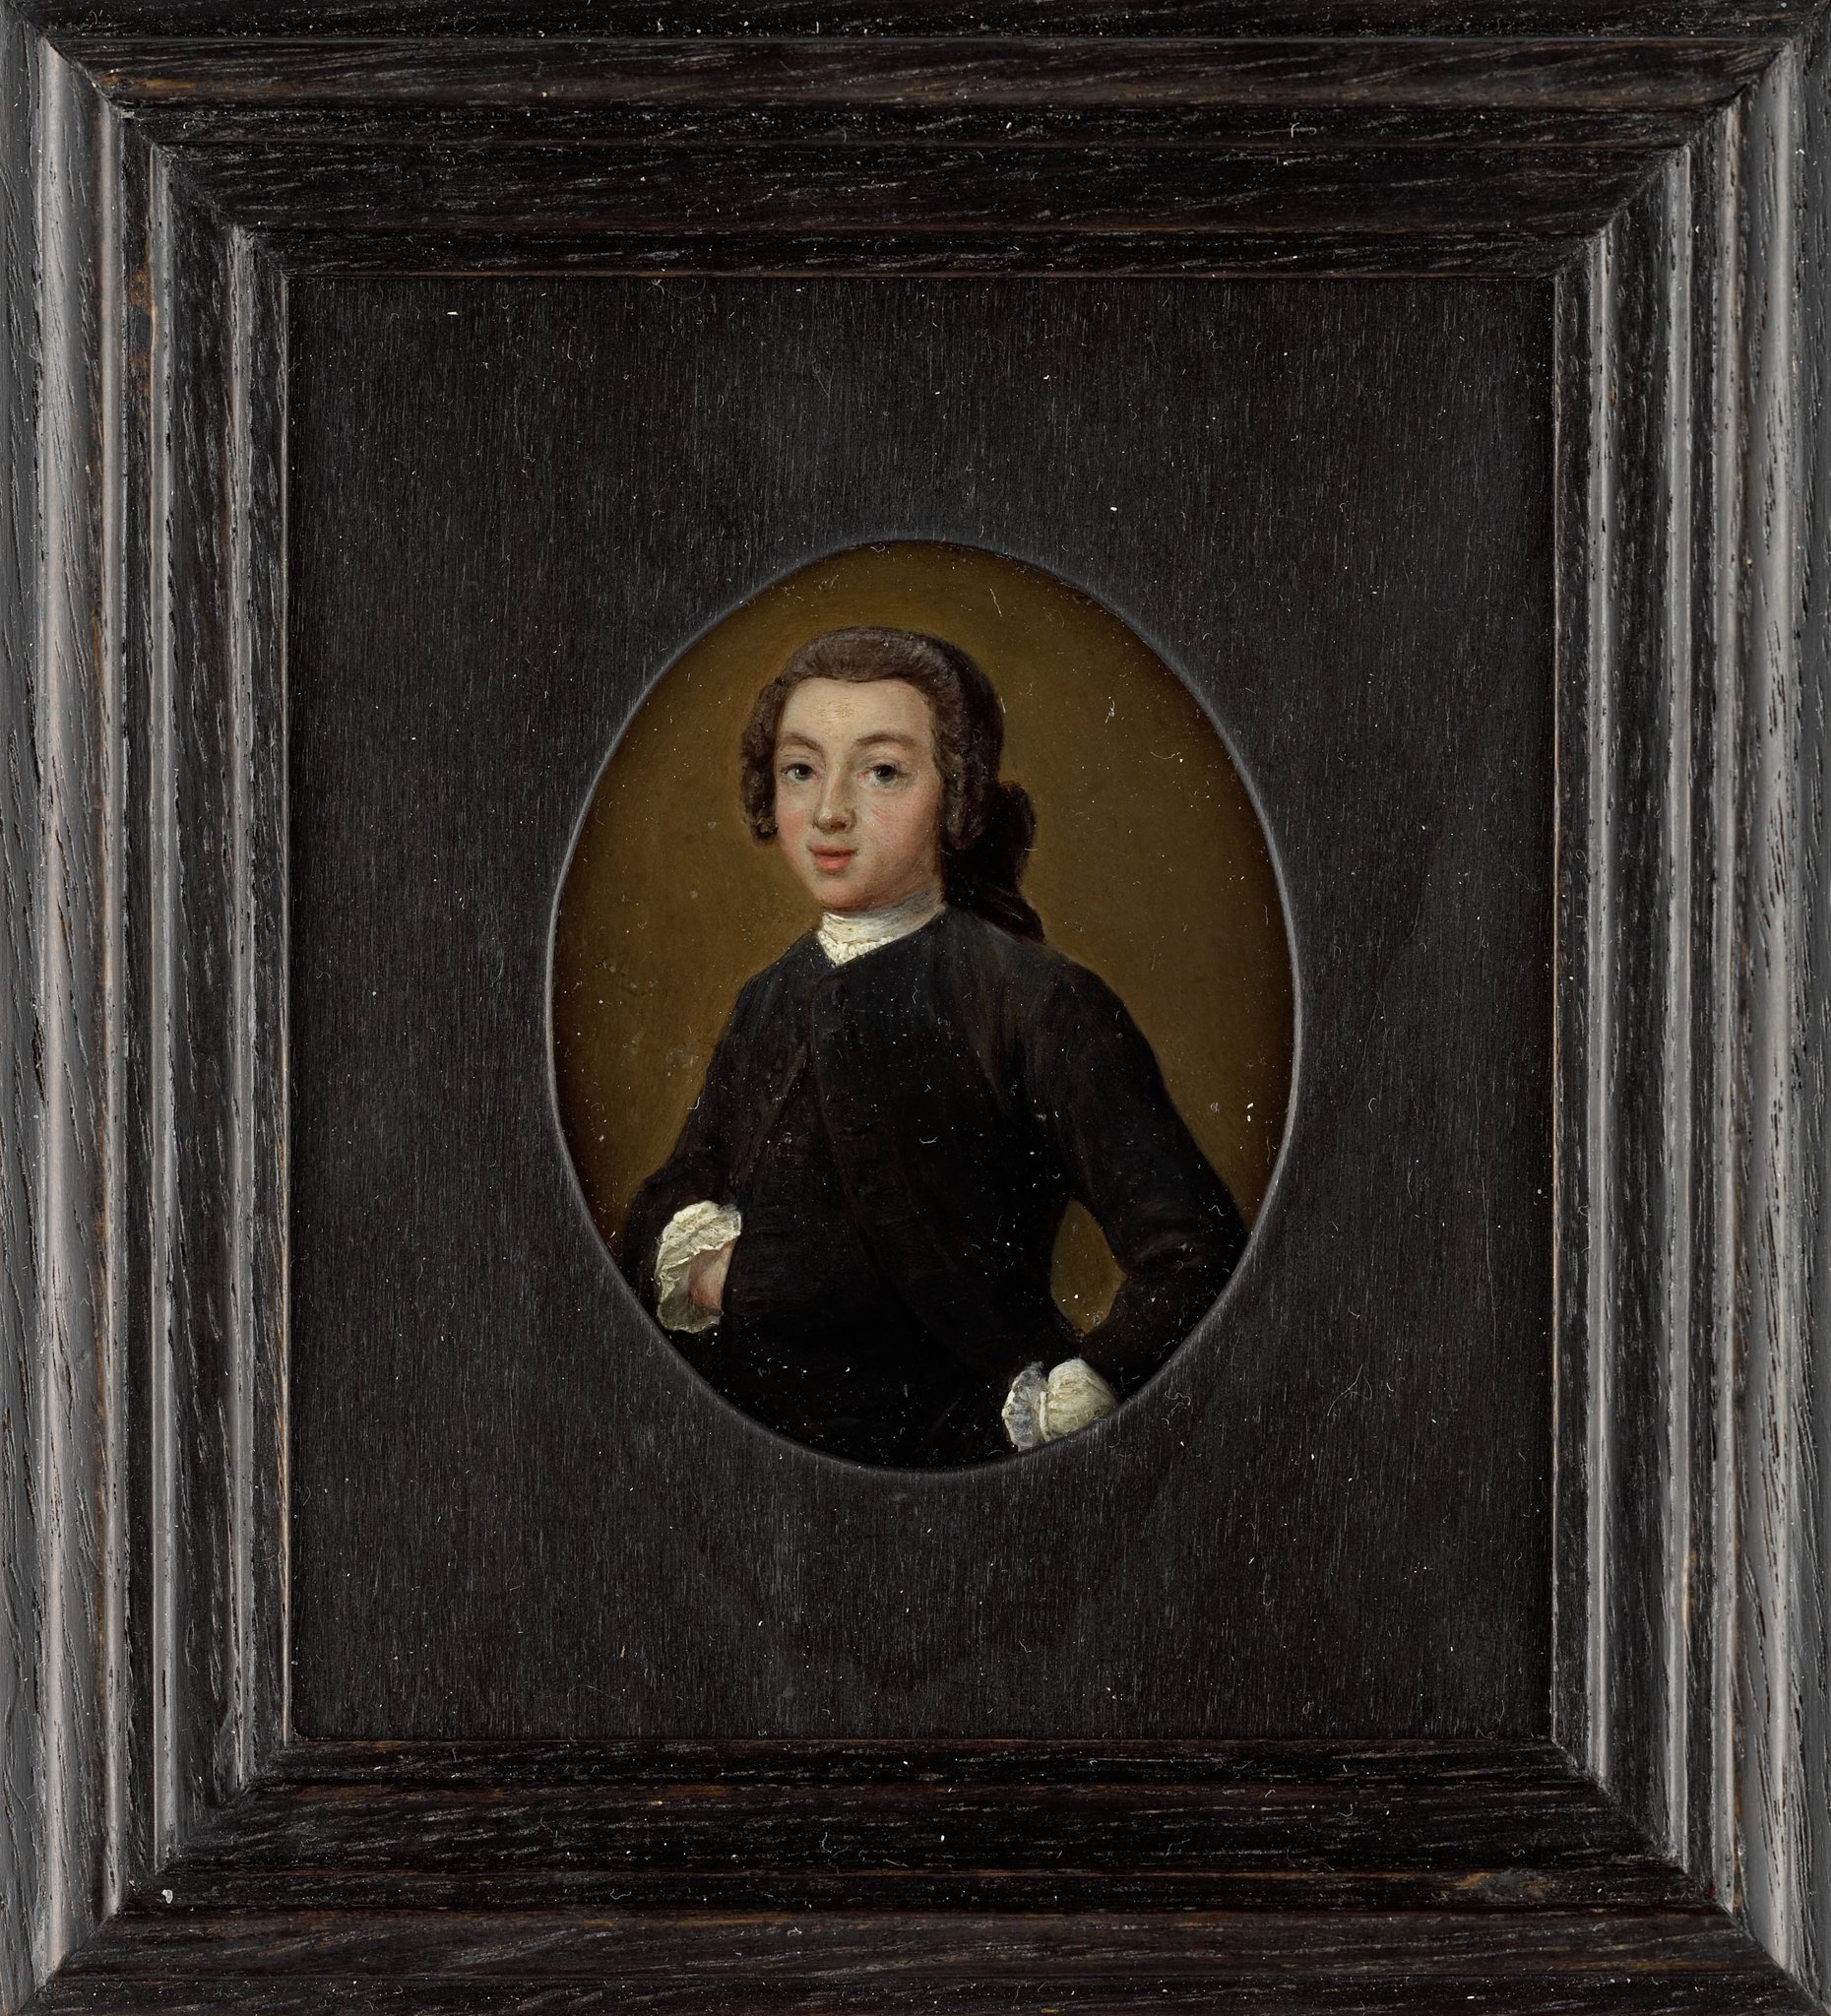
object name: painting, miniature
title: Portret van een jonge man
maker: Anonymous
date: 1745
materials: copper, wood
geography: northern netherlands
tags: anonymous historical person portrayed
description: Portret van een jonge man. Ten halven lijve, naar links, de rechterhand in de vest gestoken, de beschouwer aanziend. Onderdeel van de collectie portretminiaturen.